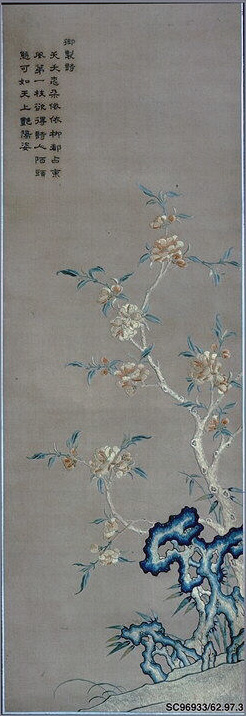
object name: panel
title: Rocks and Flowering Peach, Representing Spring; from Set of four Panels Representing the Four Seasons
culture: chinese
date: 1701-1800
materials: paint, silk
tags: flowers